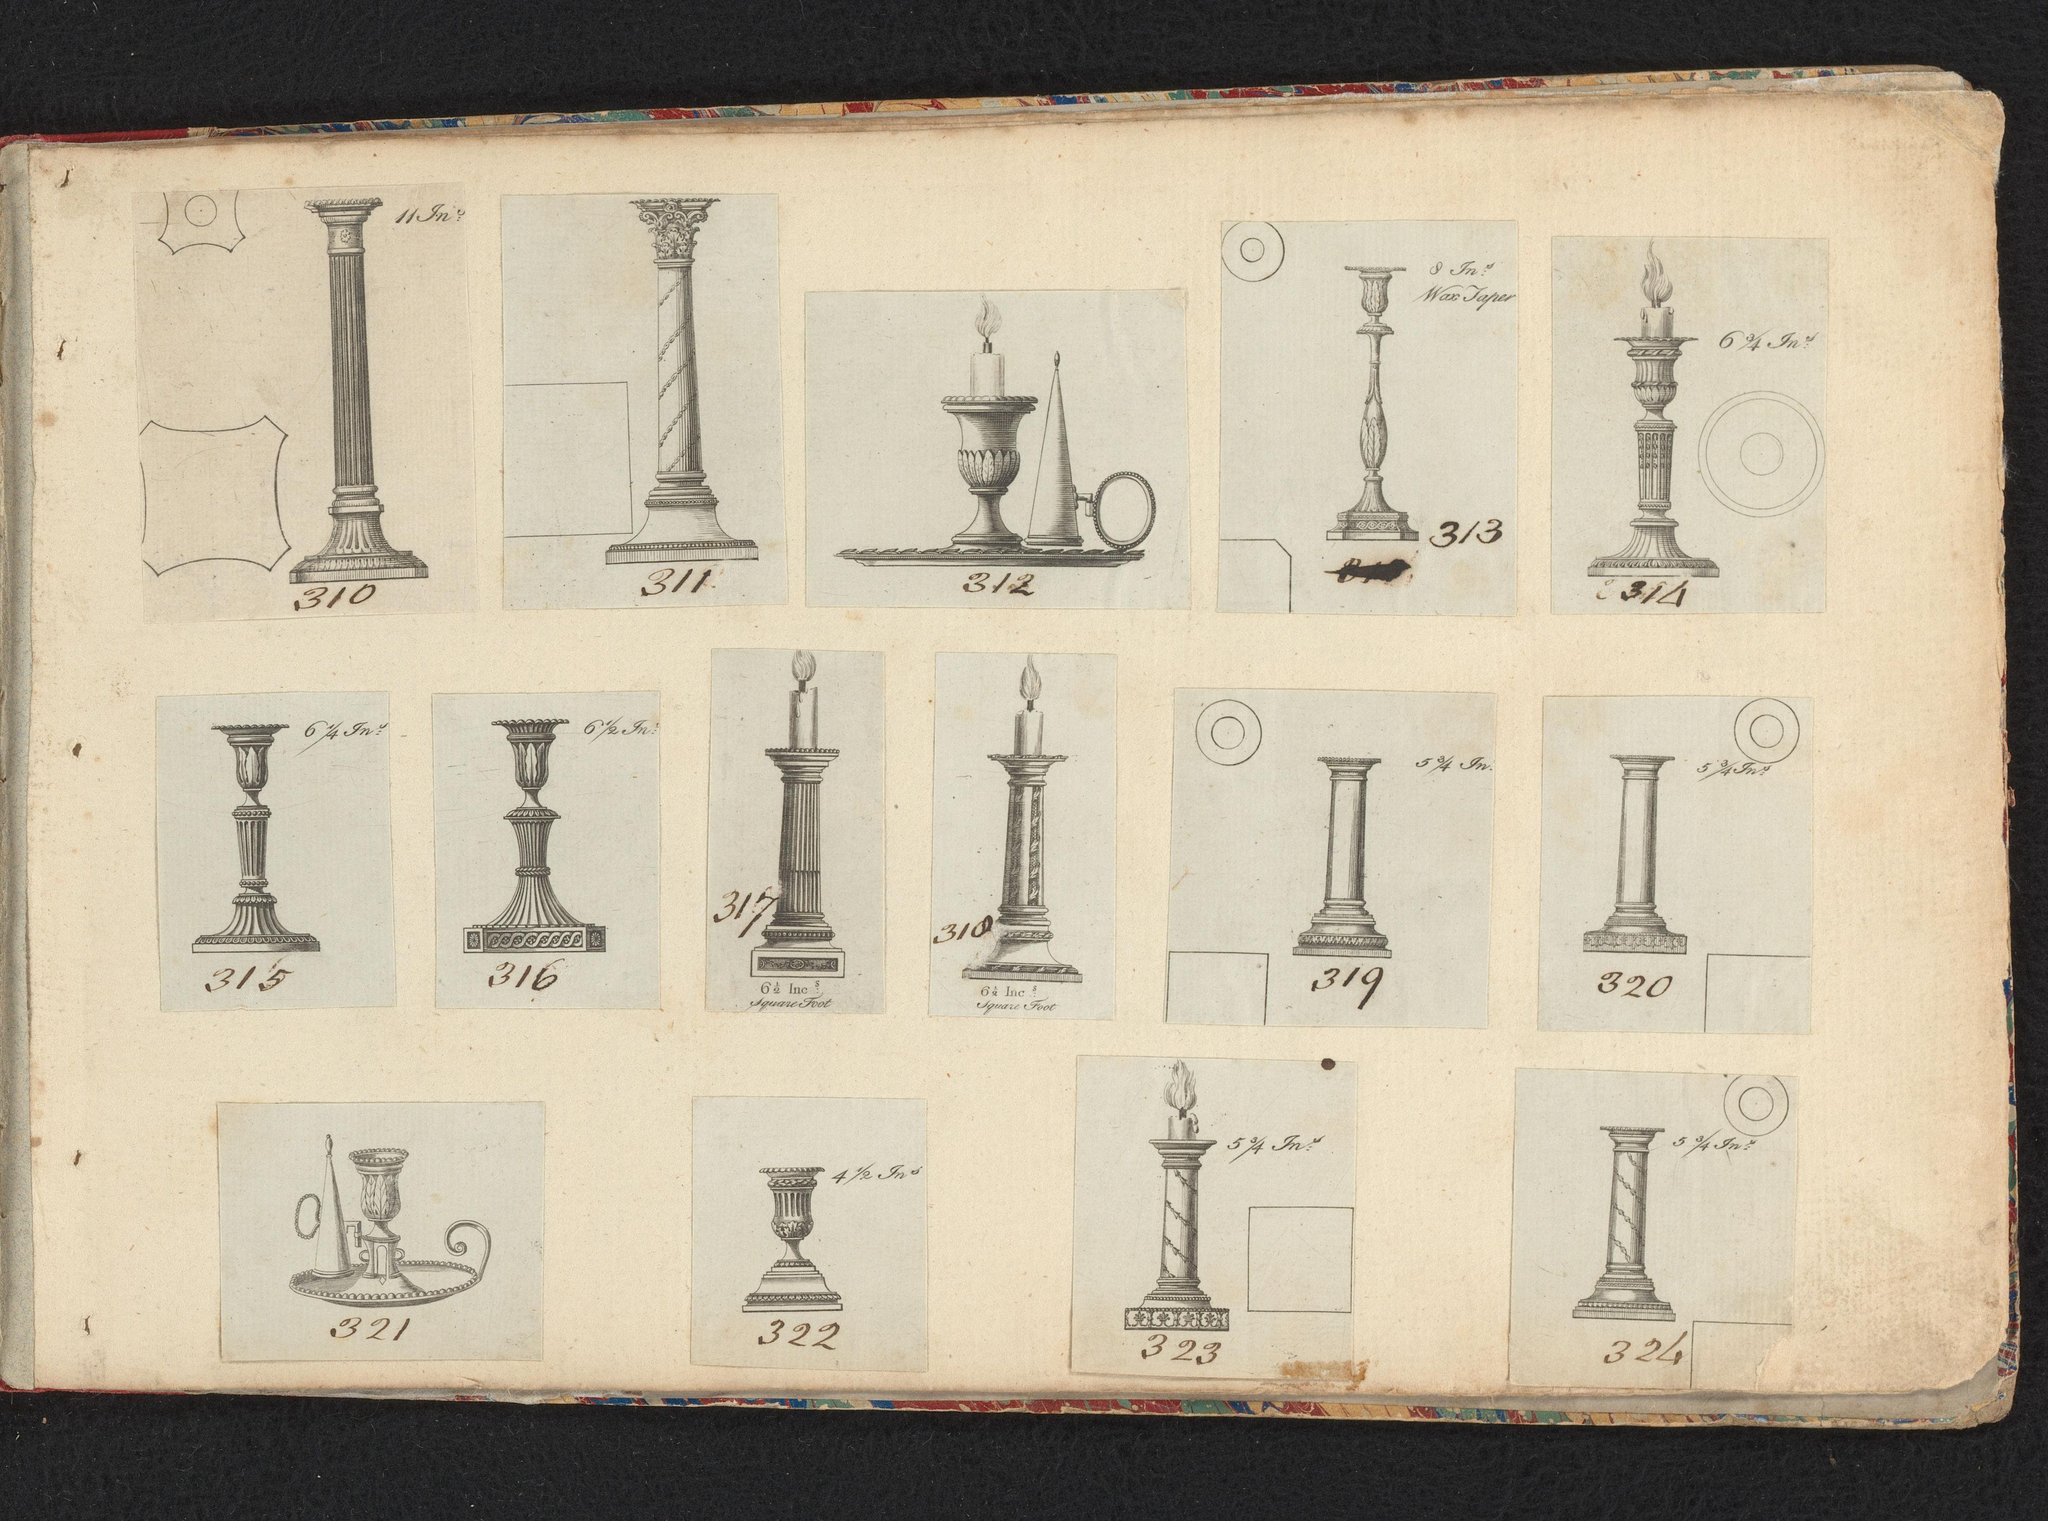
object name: print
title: Ontwerpen voor kandelaren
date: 1784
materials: paper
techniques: engraving, etching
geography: england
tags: candlestick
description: Blad met vijftien ingeplakte bladen met ontwerpen voor kandelaars. Enkele met gedrukte onderschriften. Met handgeschreven nrs. 310-324. Onderdeel van een catalogus met assortiment modellen van Sheffield verzilverd vaatwerk (pleet) door Matthew Boulton.